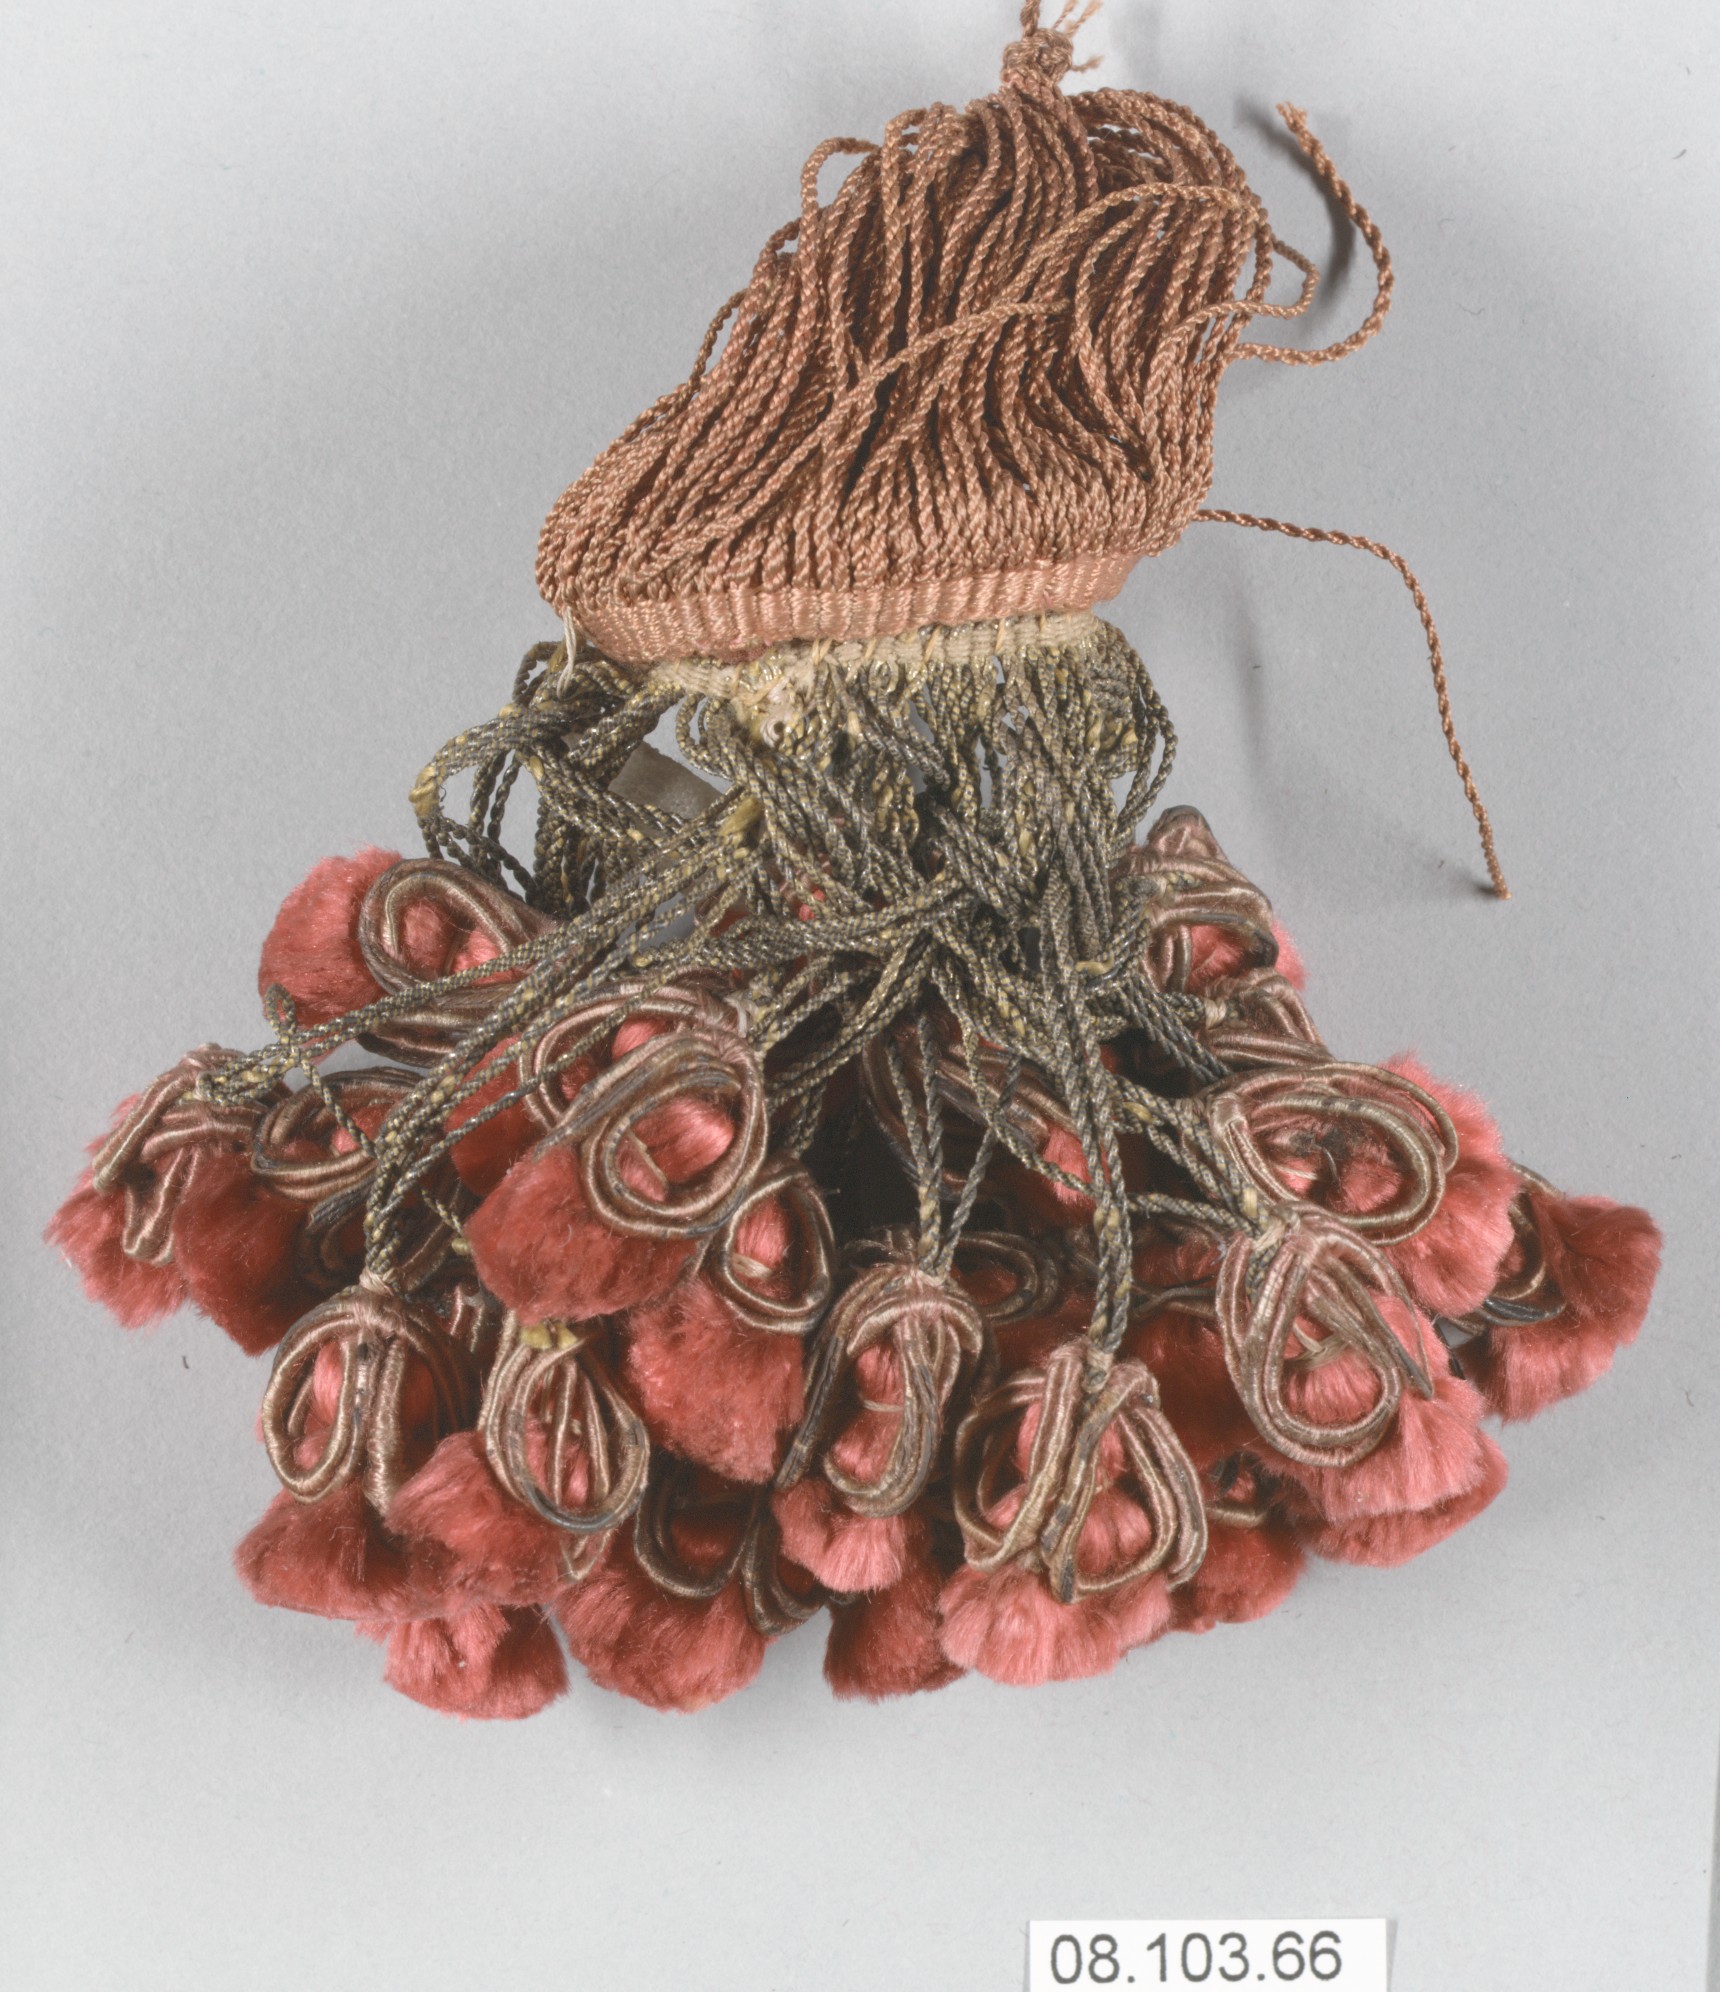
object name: tassel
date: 1501-1600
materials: metal thread, silk